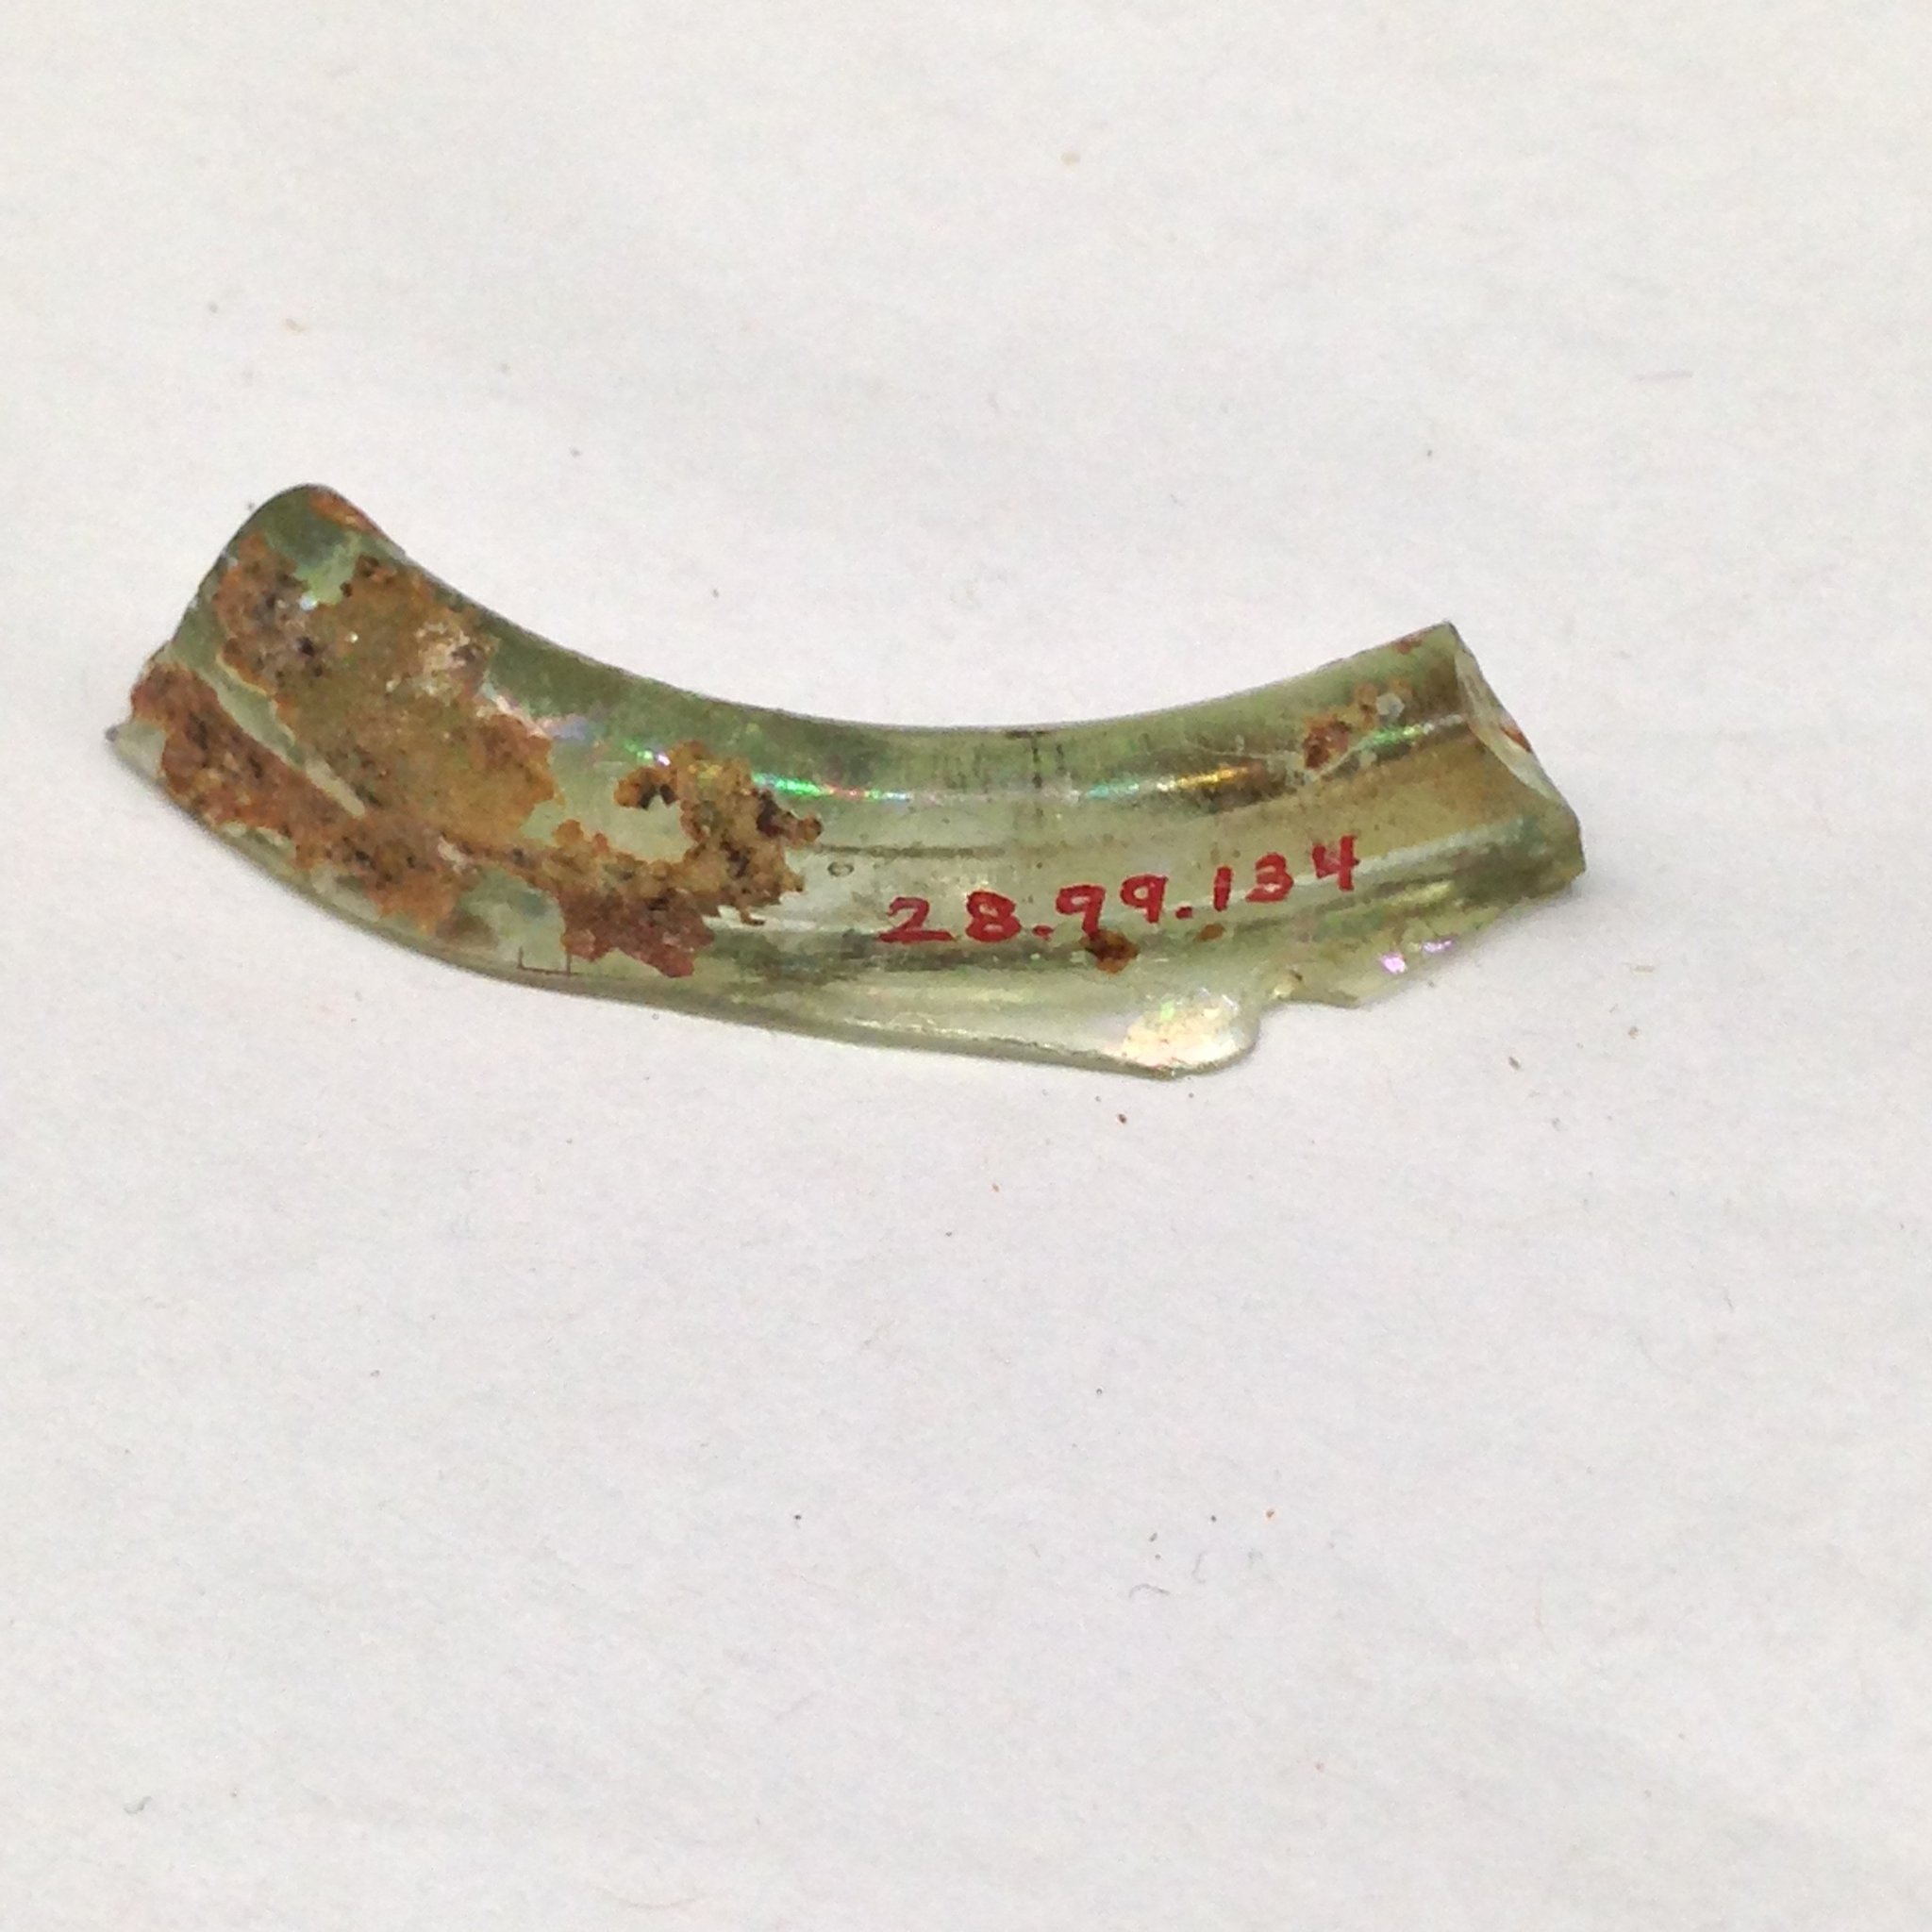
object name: fragment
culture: european or middle eastern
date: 1150-1250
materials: ceramic, glass